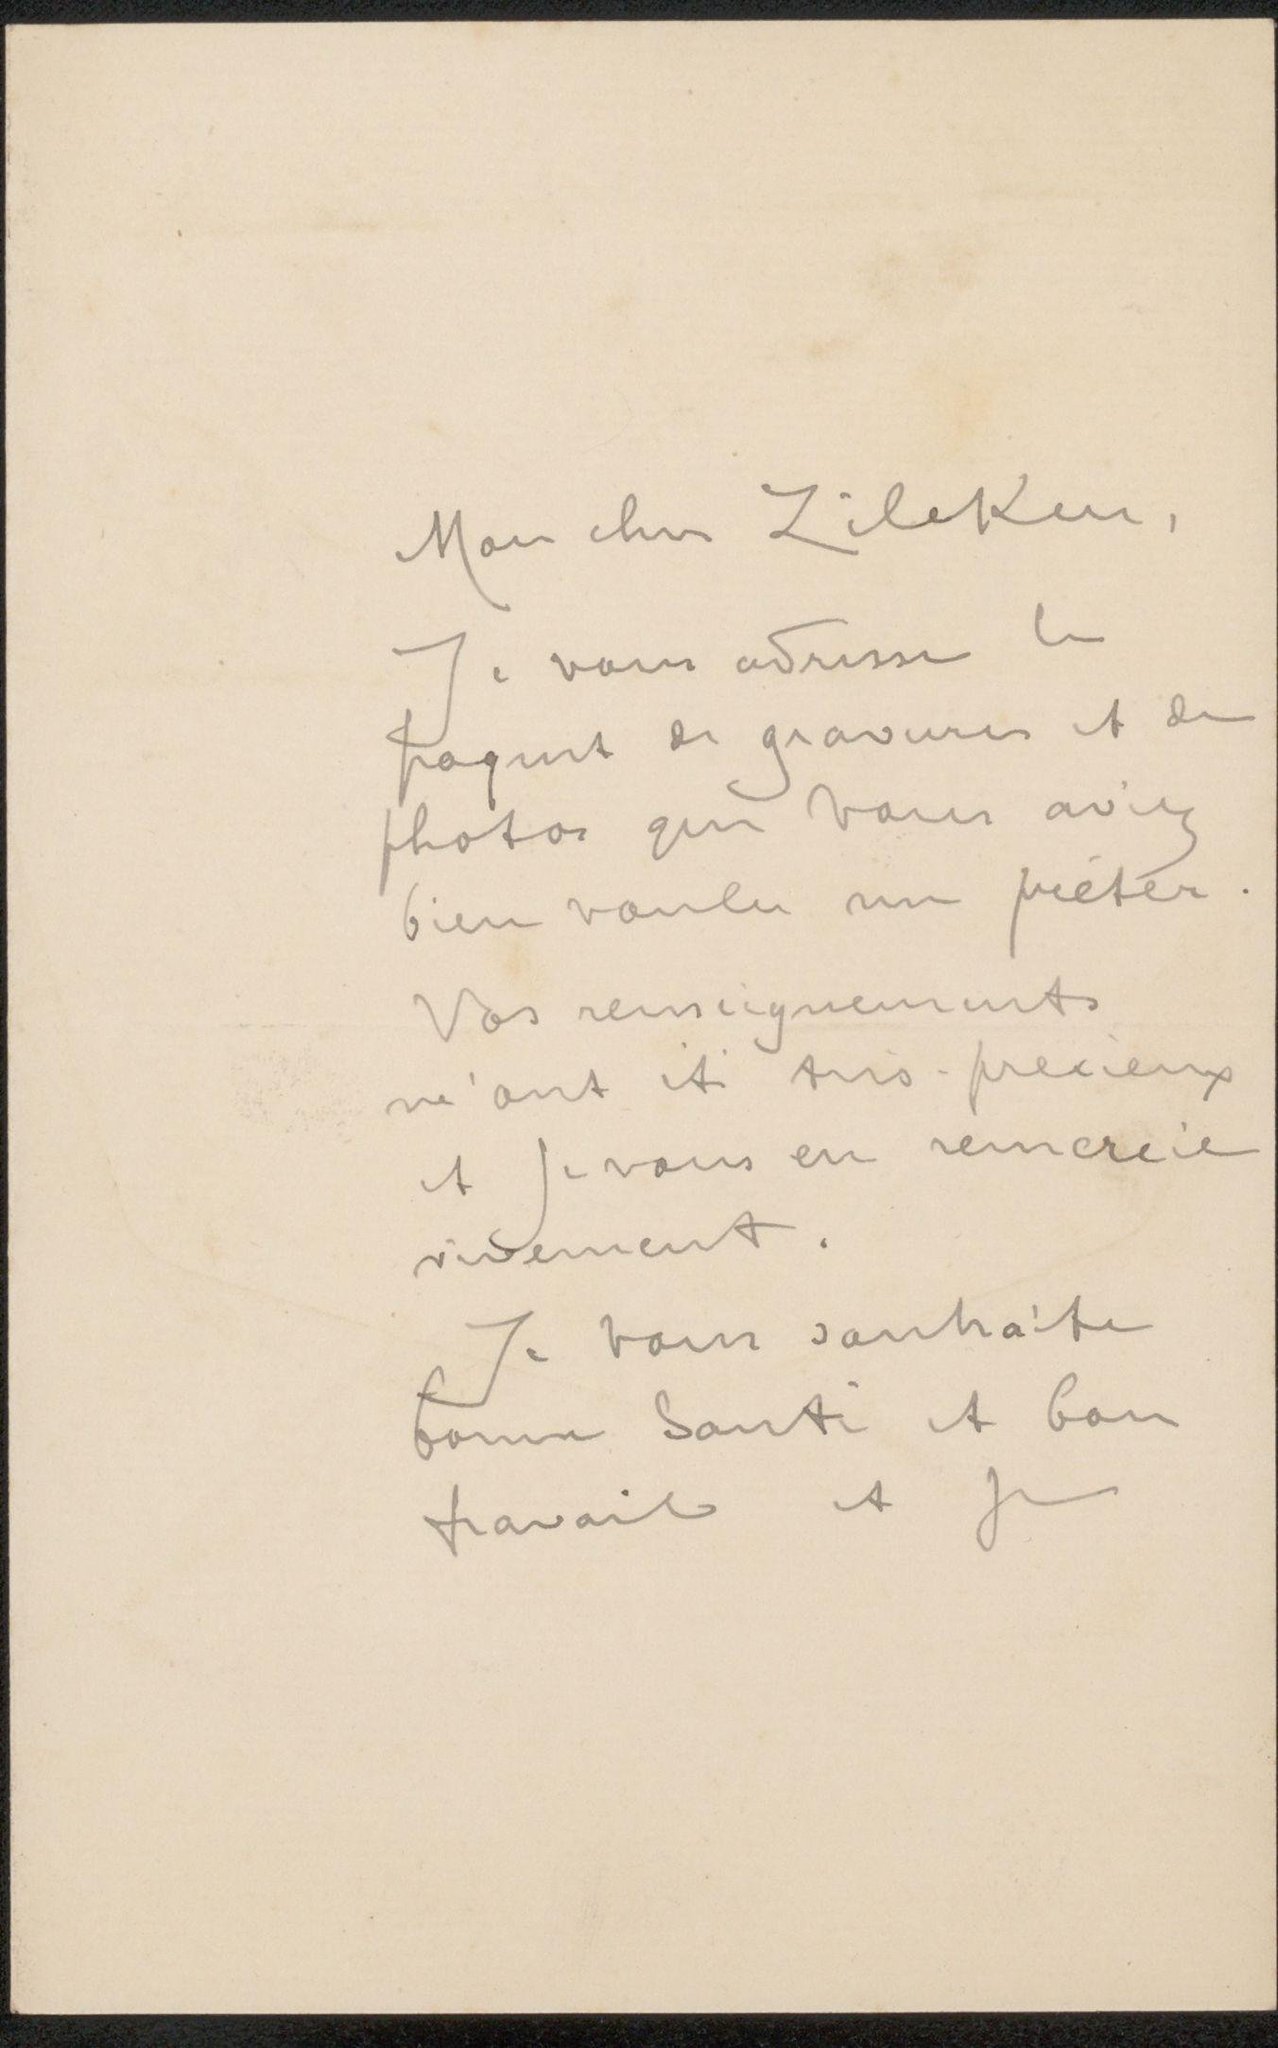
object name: letter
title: Brief aan Philip Zilcken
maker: fernand khnopff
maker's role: draughtsman, print maker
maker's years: 1858-1921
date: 1868-1921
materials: ink, paper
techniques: pen, writing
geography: brussels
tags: the hague, painter, philip zilcken, photography, cinematography, the graphic arts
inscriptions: collector's mark: ‘RPK’